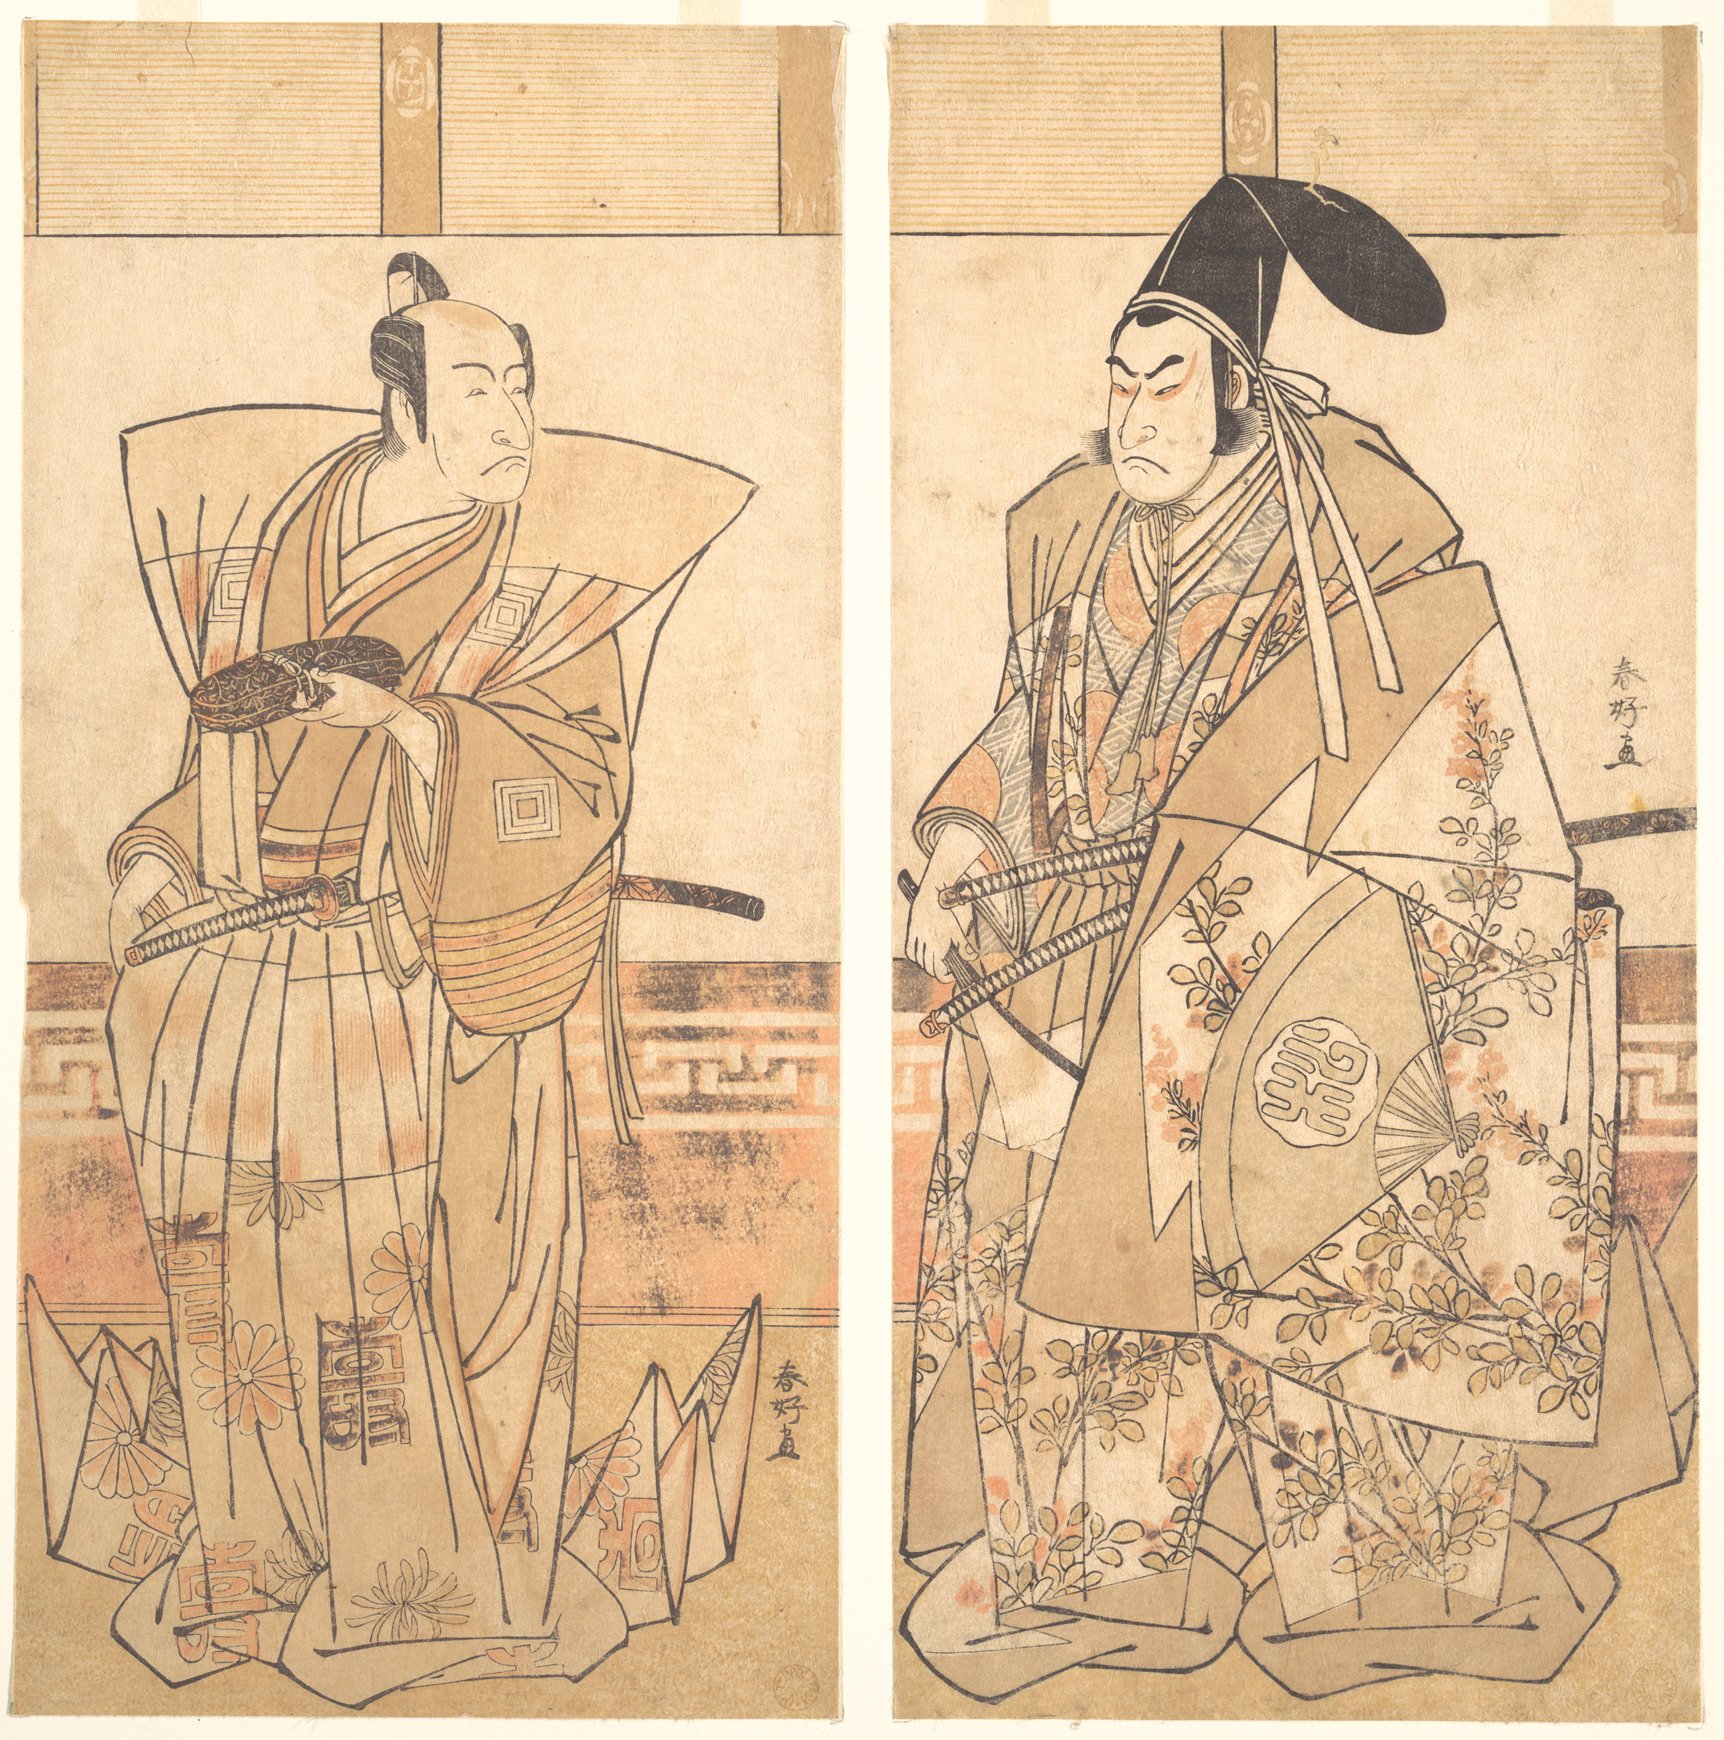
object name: print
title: Two Actors Dressed in Ceremonial Costumes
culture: japanese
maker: katsukawa shunkō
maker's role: artist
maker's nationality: japanese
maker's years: 1743-1812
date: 1787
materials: ink, paper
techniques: woodblock print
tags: swords,men,actors